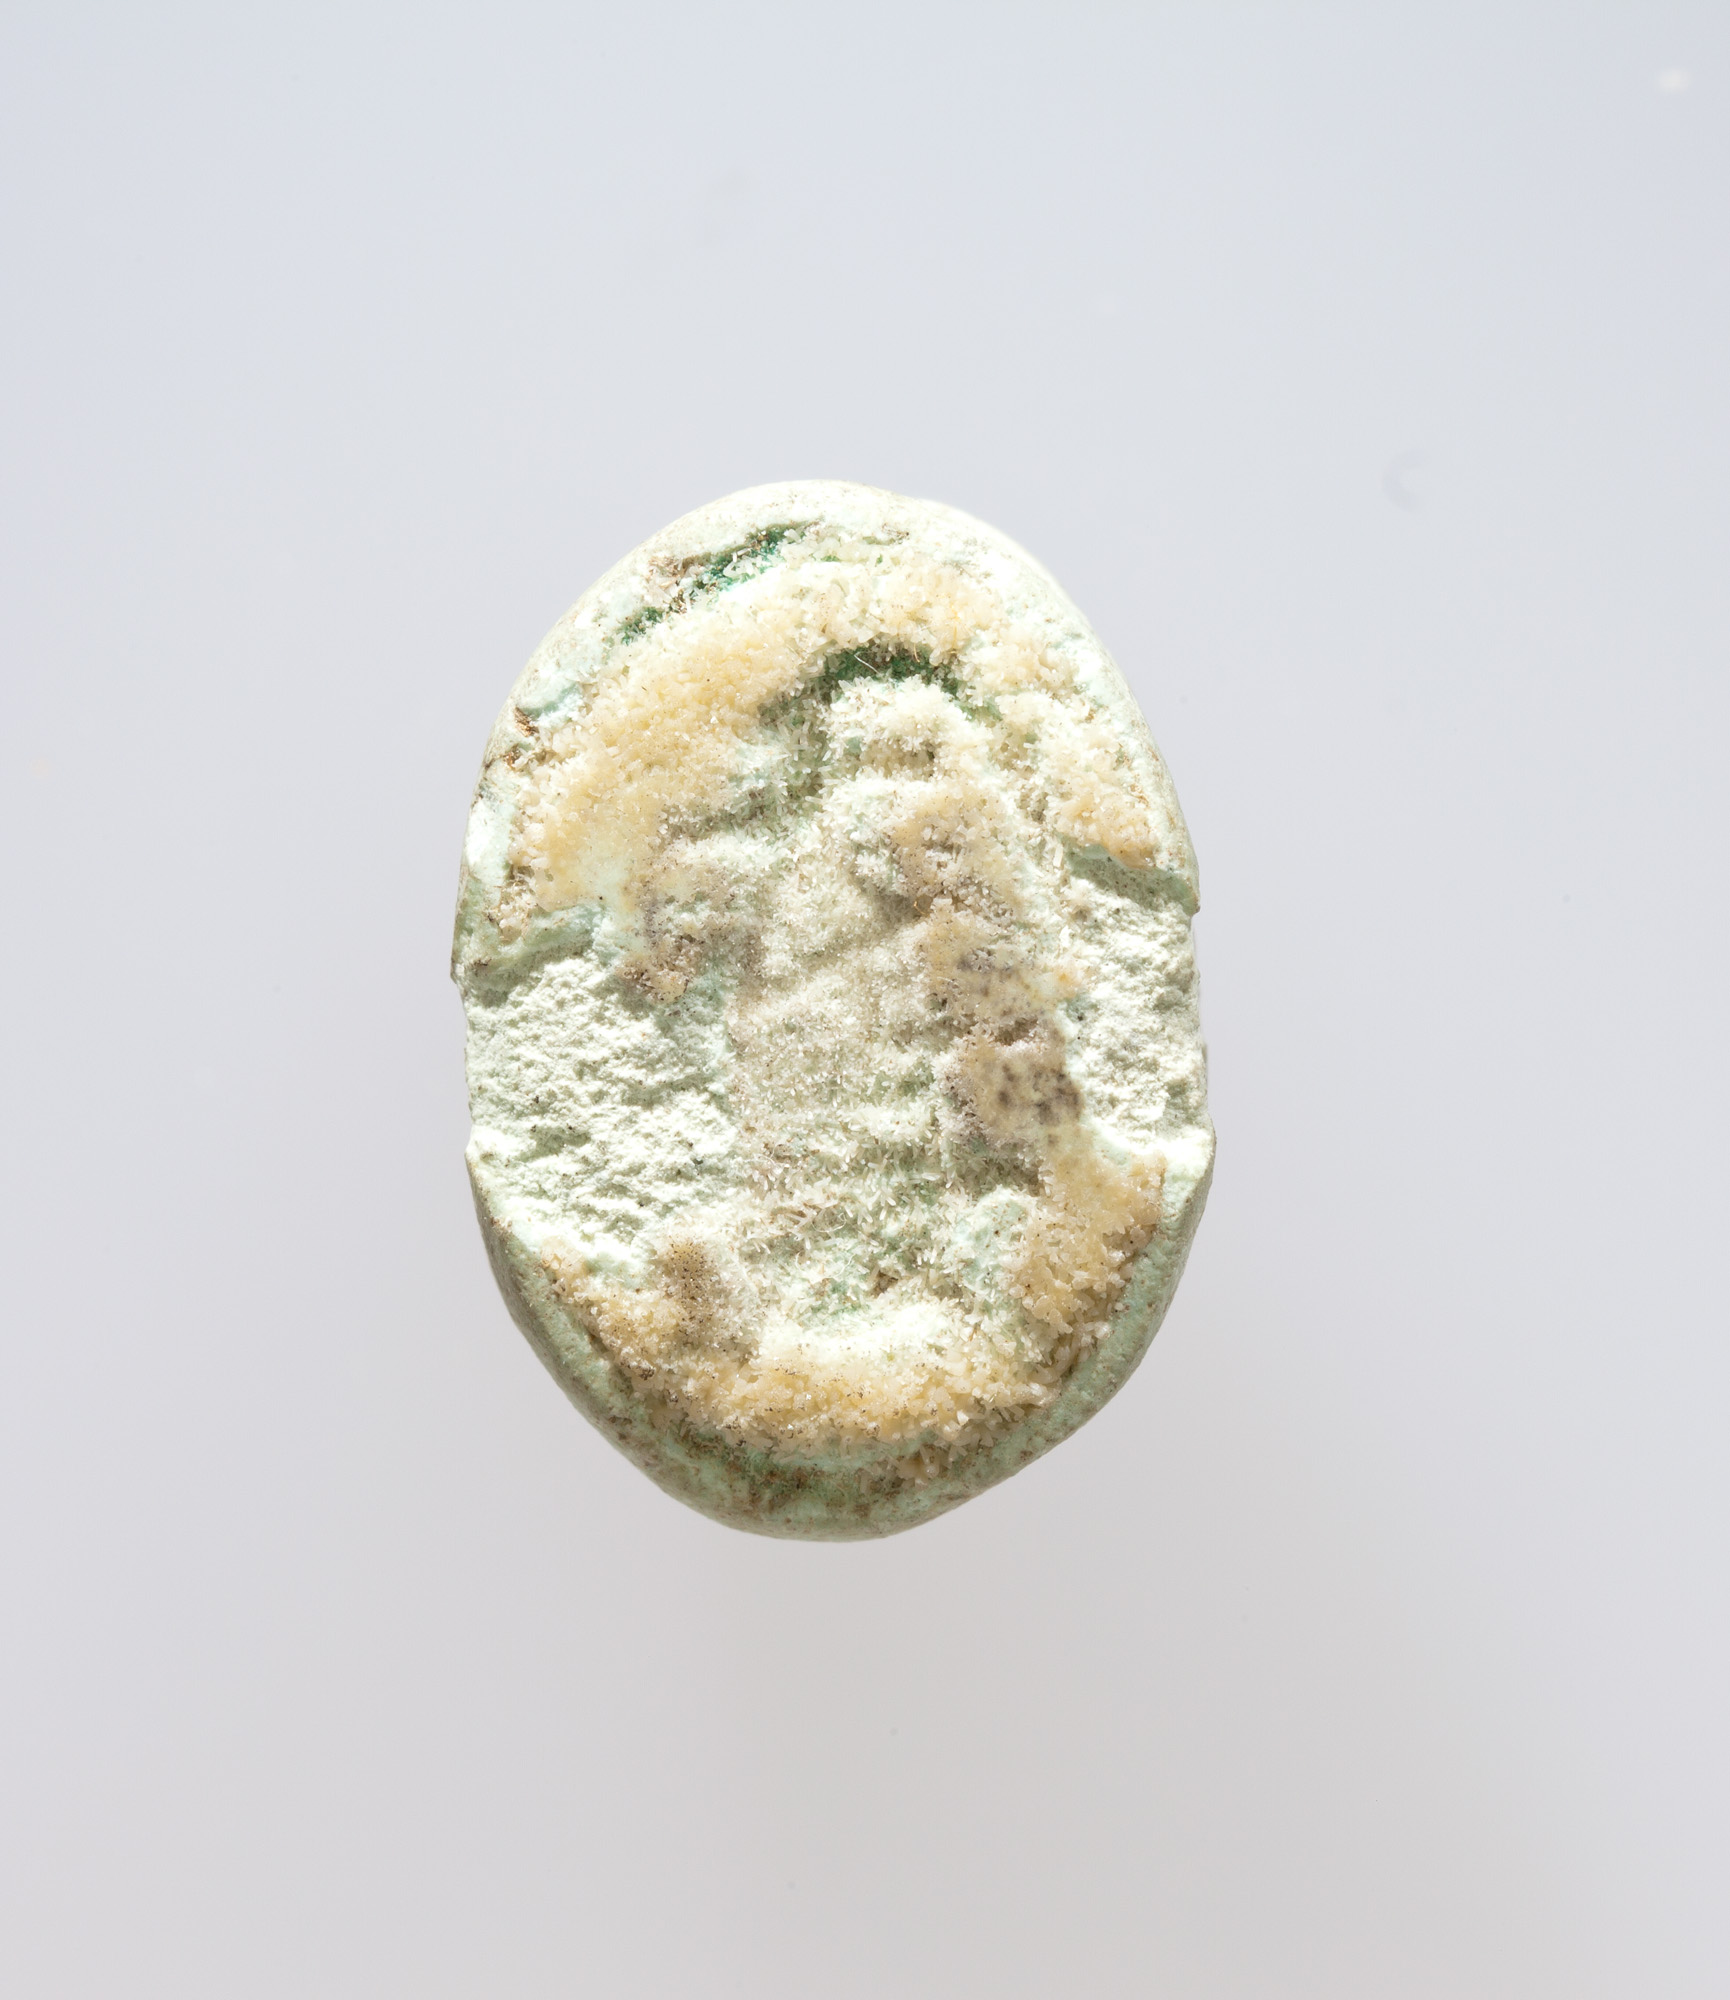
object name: scarab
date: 1479-1458 BCE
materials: faience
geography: egypt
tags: scarabs